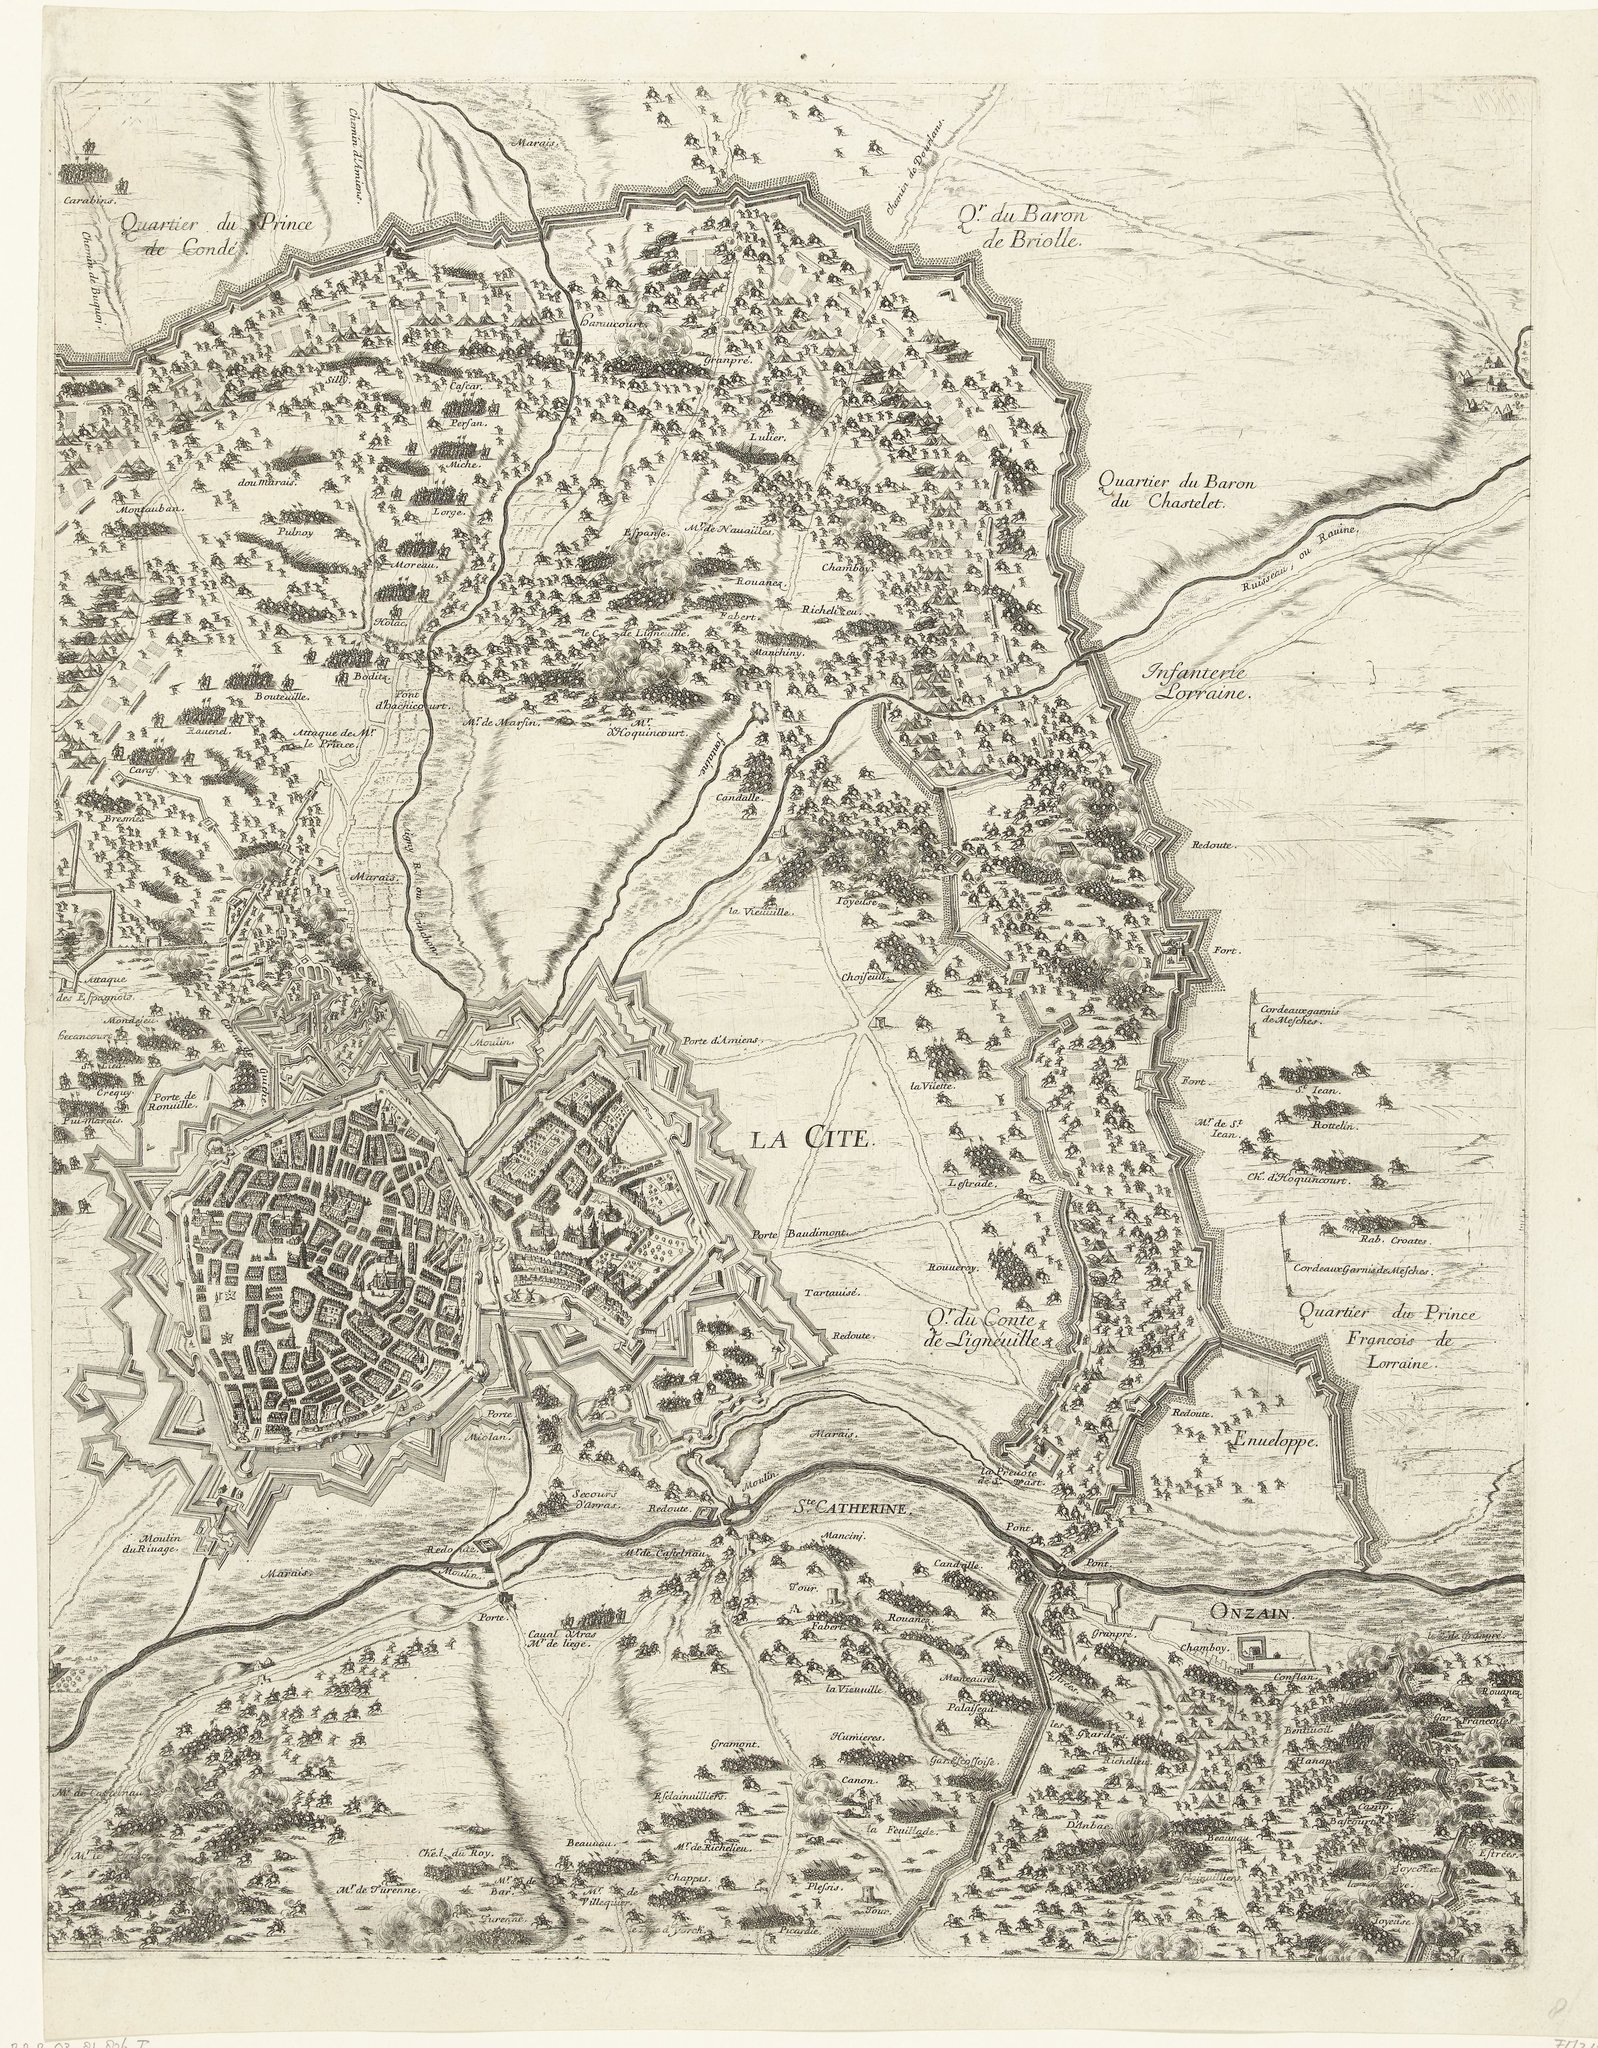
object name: propagandaprent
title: Le siege d'Arras leve par la defaite des ennemis 1654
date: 1655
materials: paper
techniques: engraving, etching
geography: france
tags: vienna, leopold willem van oostenrijk (landvoogd der zuidelijke nederlanden), raising the siege with outside assistance, relief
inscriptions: date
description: Ontzet van de stad Arras (Atrecht), belegerd door de Spanjaarden, 23-25 augustus 1654. Arras ontzet door het Franse leger onder de maarschalk Turenne van het beleg door de Spanjaarden onder Louis de Condé en aartshertog Leopold Willem. Derde blad in de middelste rij. Deel van de kaart van het beleg met de plattegrond van de stad. Onderdeel van een ongemonteerd geheel bestaande uit een titelblad en een grote voorstelling op vijftien platen (de halve plaat rechtsonder ontbreekt).